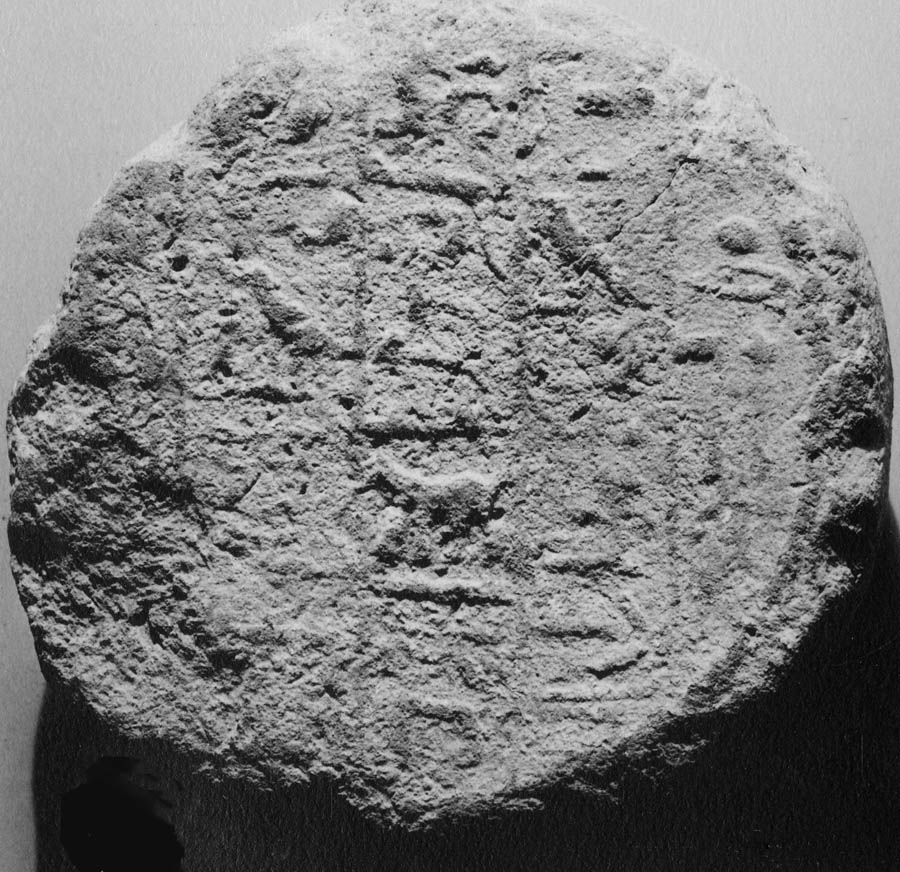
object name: cone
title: Funerary Cone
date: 1550-1295 BCE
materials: pottery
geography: egypt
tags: hieroglyphs